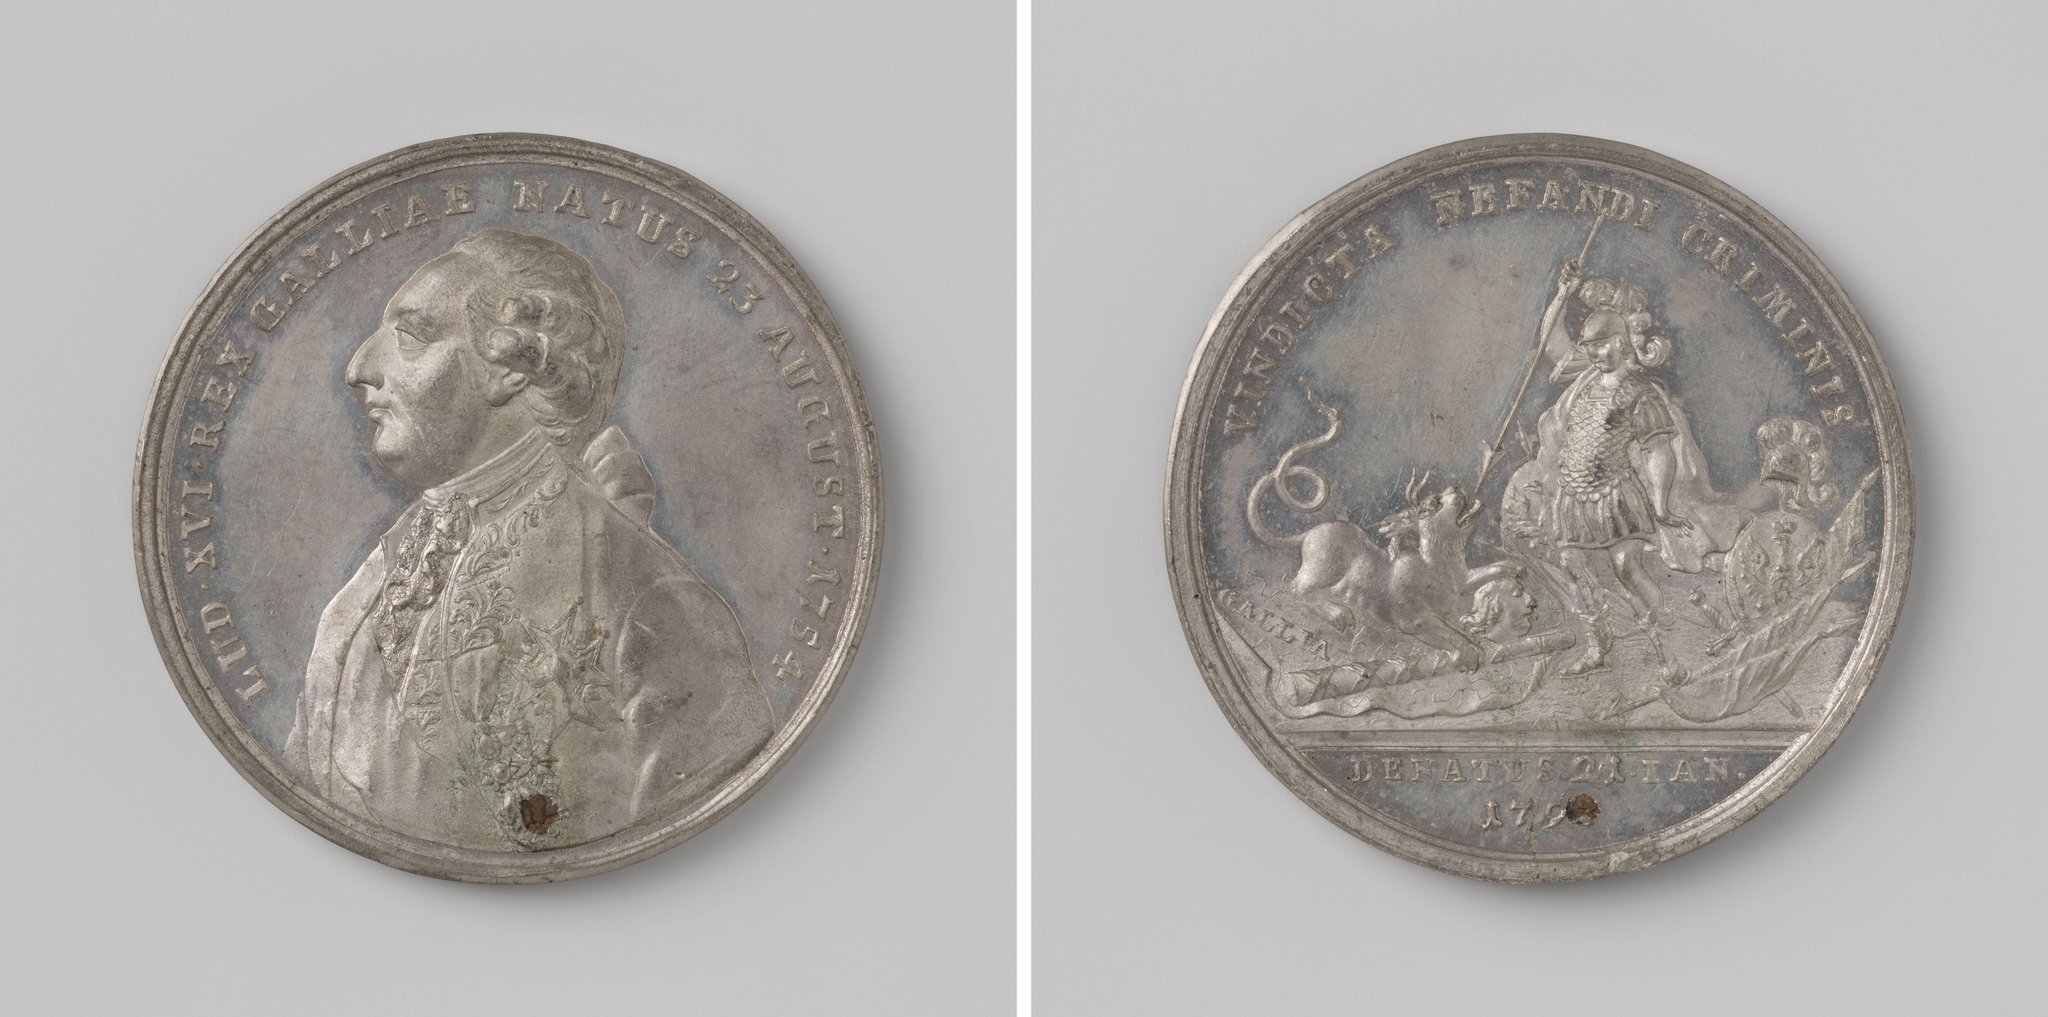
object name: history medal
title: Terechtstelling van Lodewijk XVI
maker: Anonymous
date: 1793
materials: silver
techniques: striking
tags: paris, lodewijk xvi (koning van frankrijk)